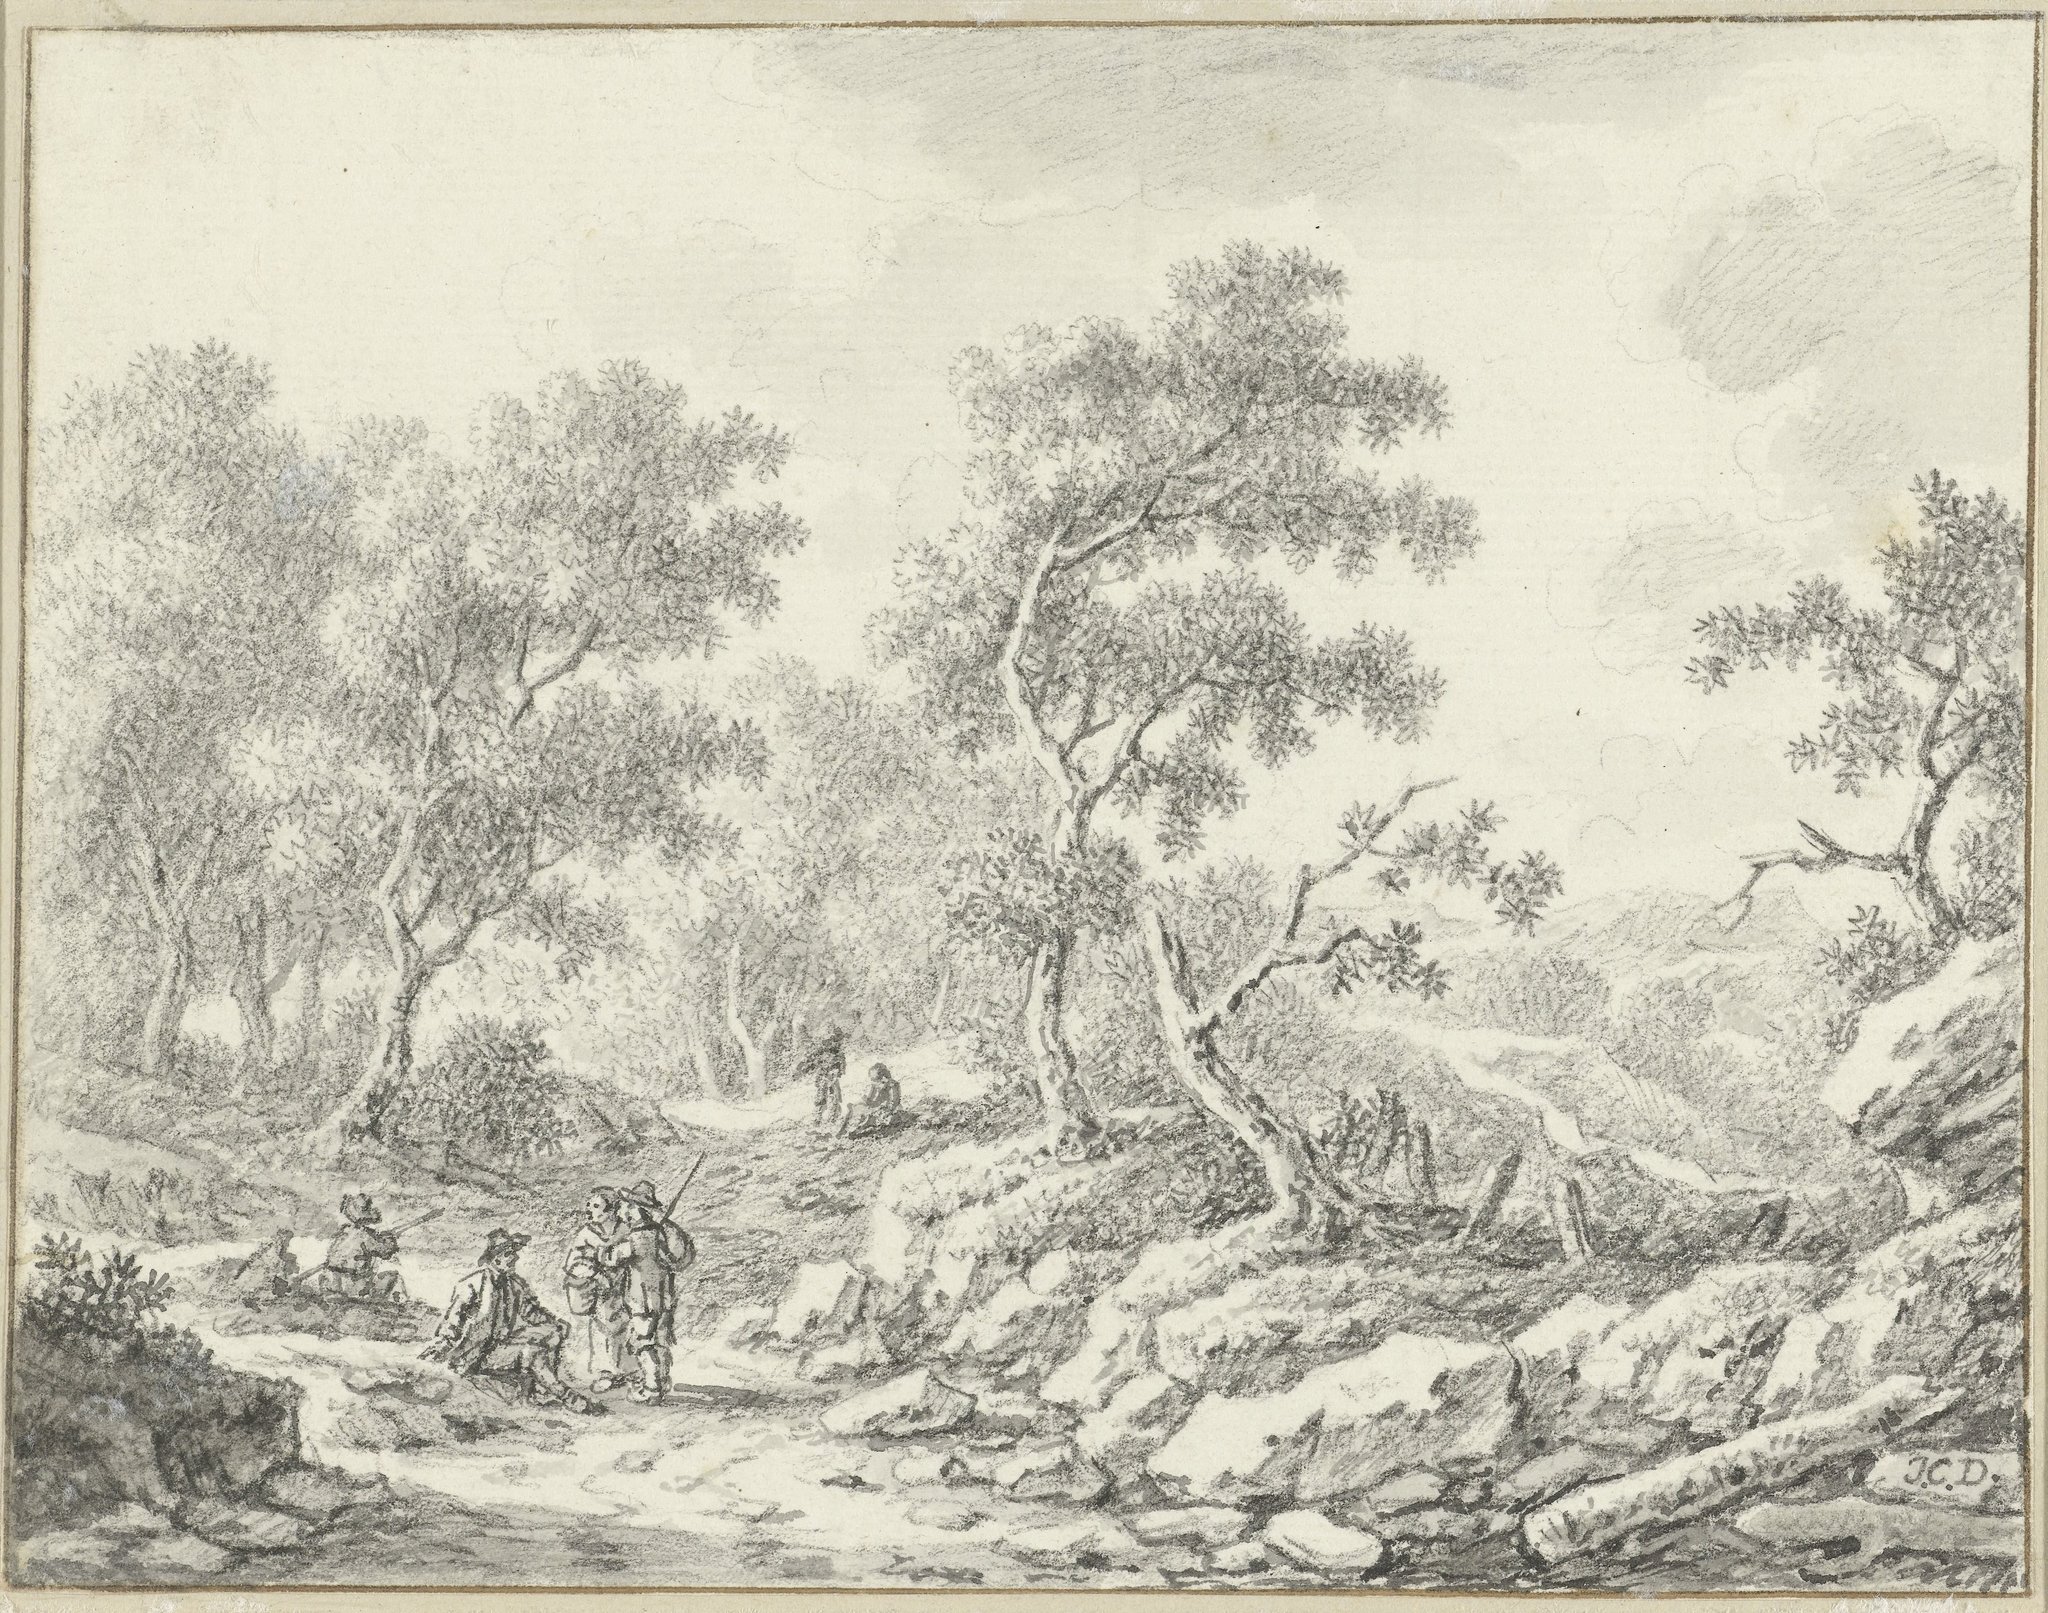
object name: drawing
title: Rustende en wandelende personen in boomrijk landschap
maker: johann christoph dietzsch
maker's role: draughtsman, print maker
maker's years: 1710-1769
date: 1720-1769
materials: chalk, paper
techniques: brush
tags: (traveller) resting in the open air, forest, wood